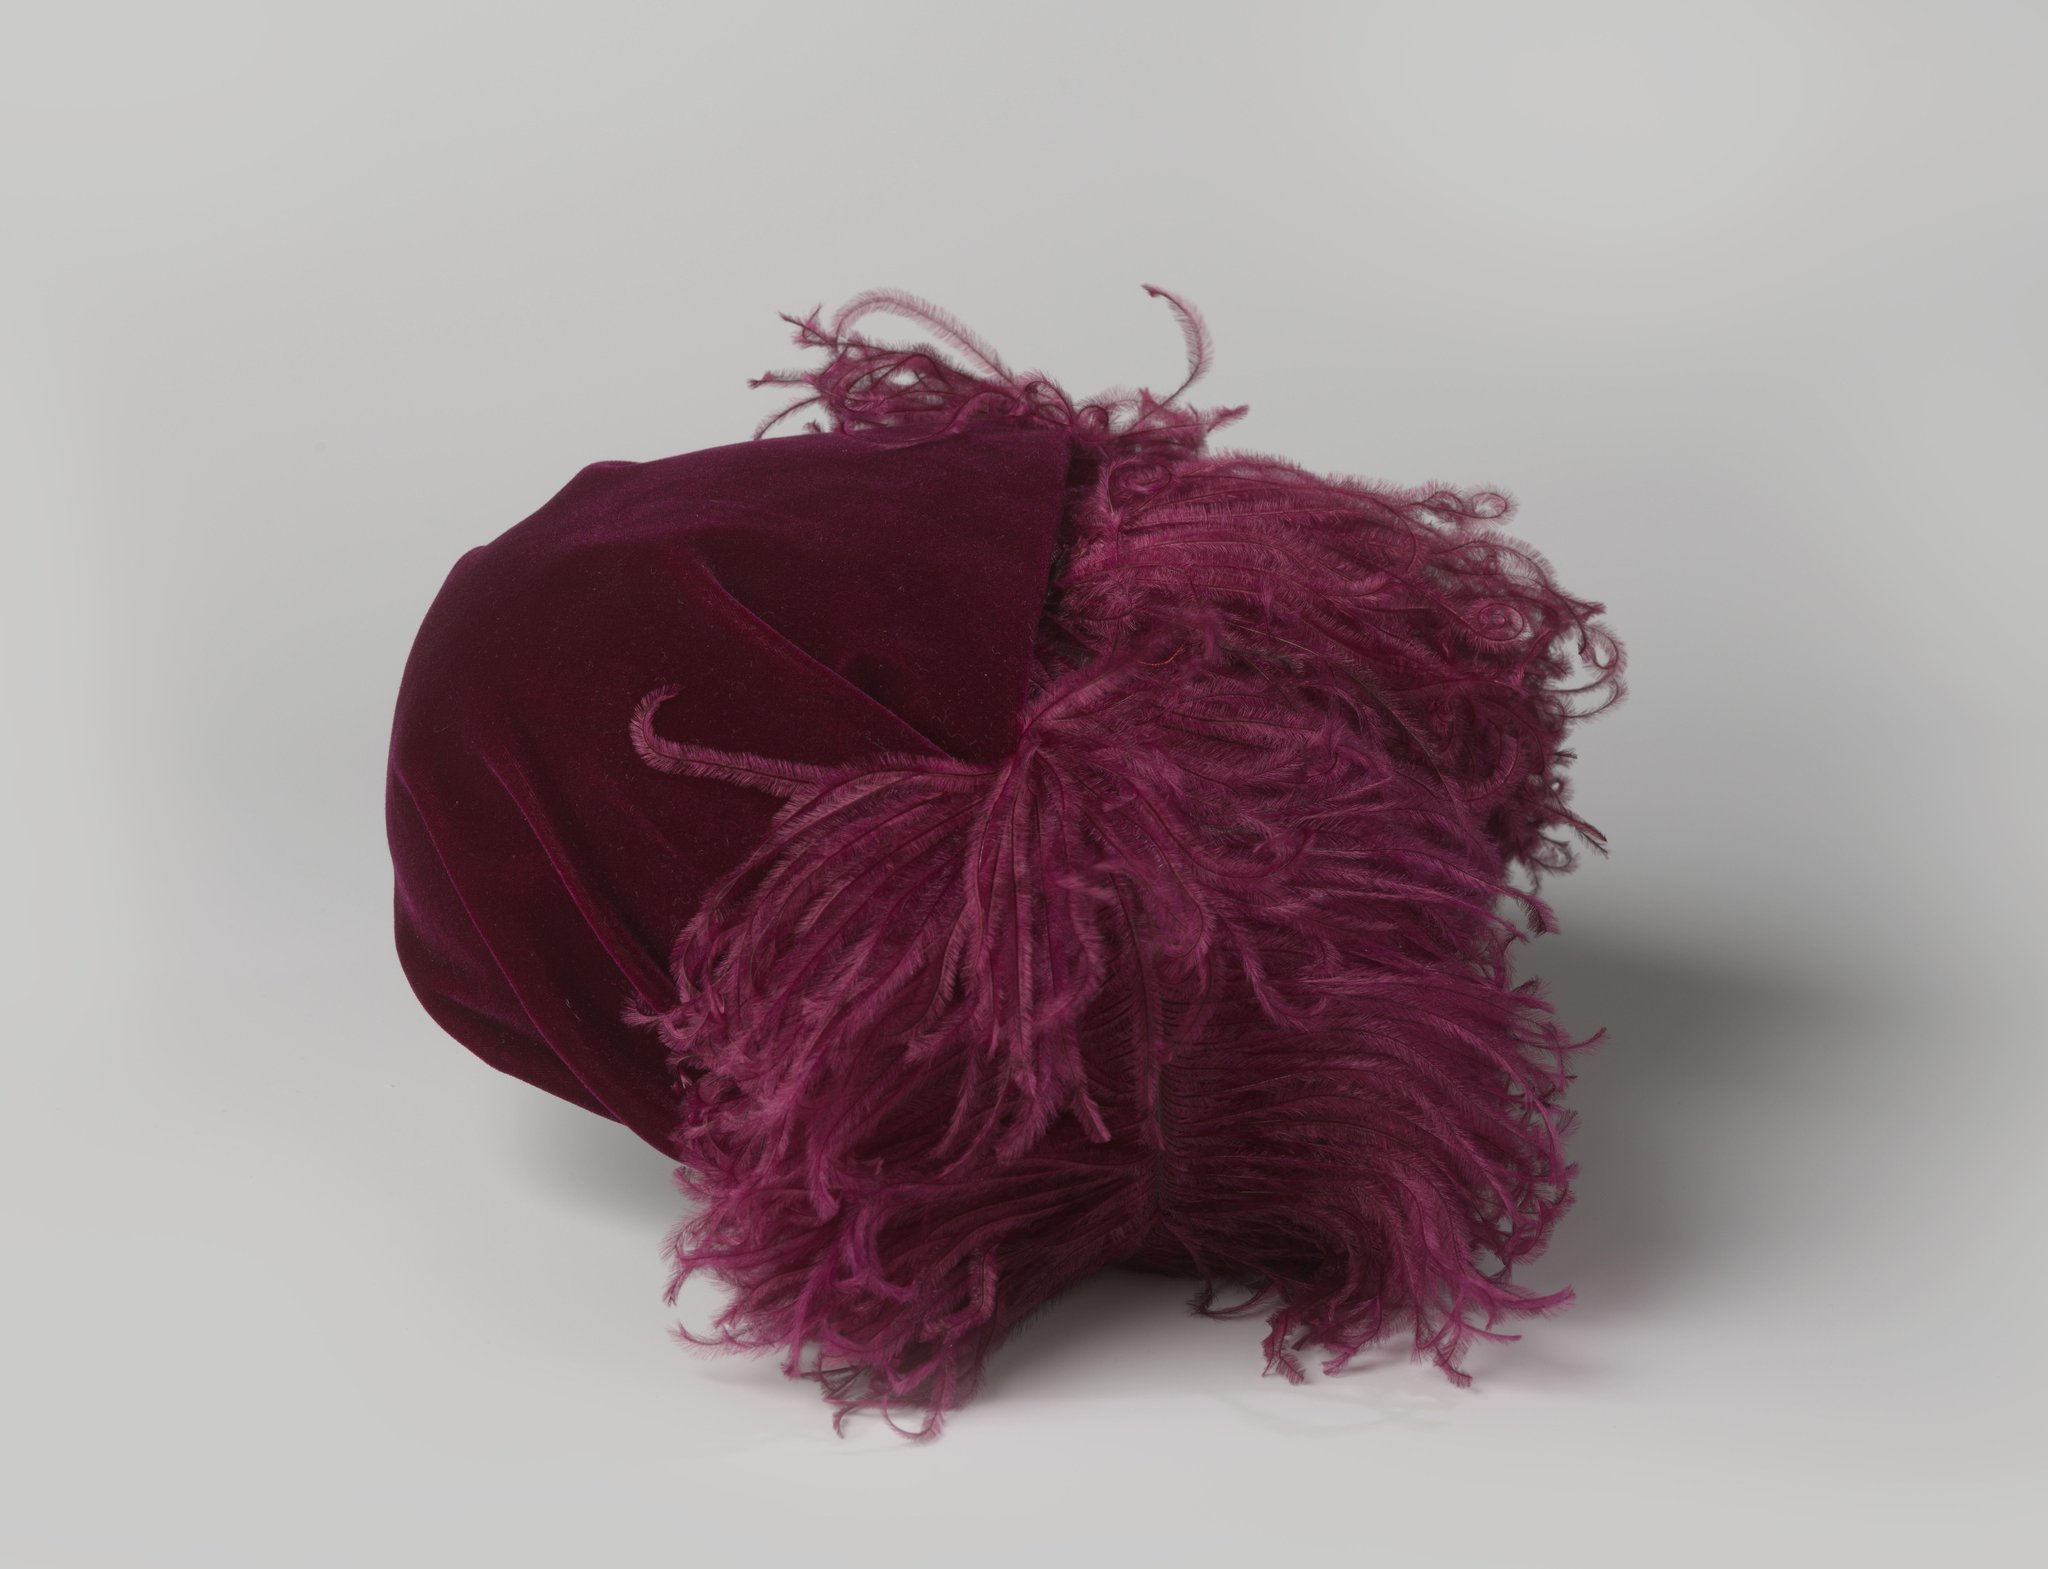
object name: womenswear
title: Baret van bordeauxrode zijdevelours afgezet met rode struisveren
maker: paulette modes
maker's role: hoedenmaakster, modiste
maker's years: 1900-1984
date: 1960-1970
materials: silk, velvet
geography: paris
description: Baret van bordeauxrode zijdevelours afgezet met rode struisveren. Aan de binnenzijde een label waarop staat: PAULETTE.